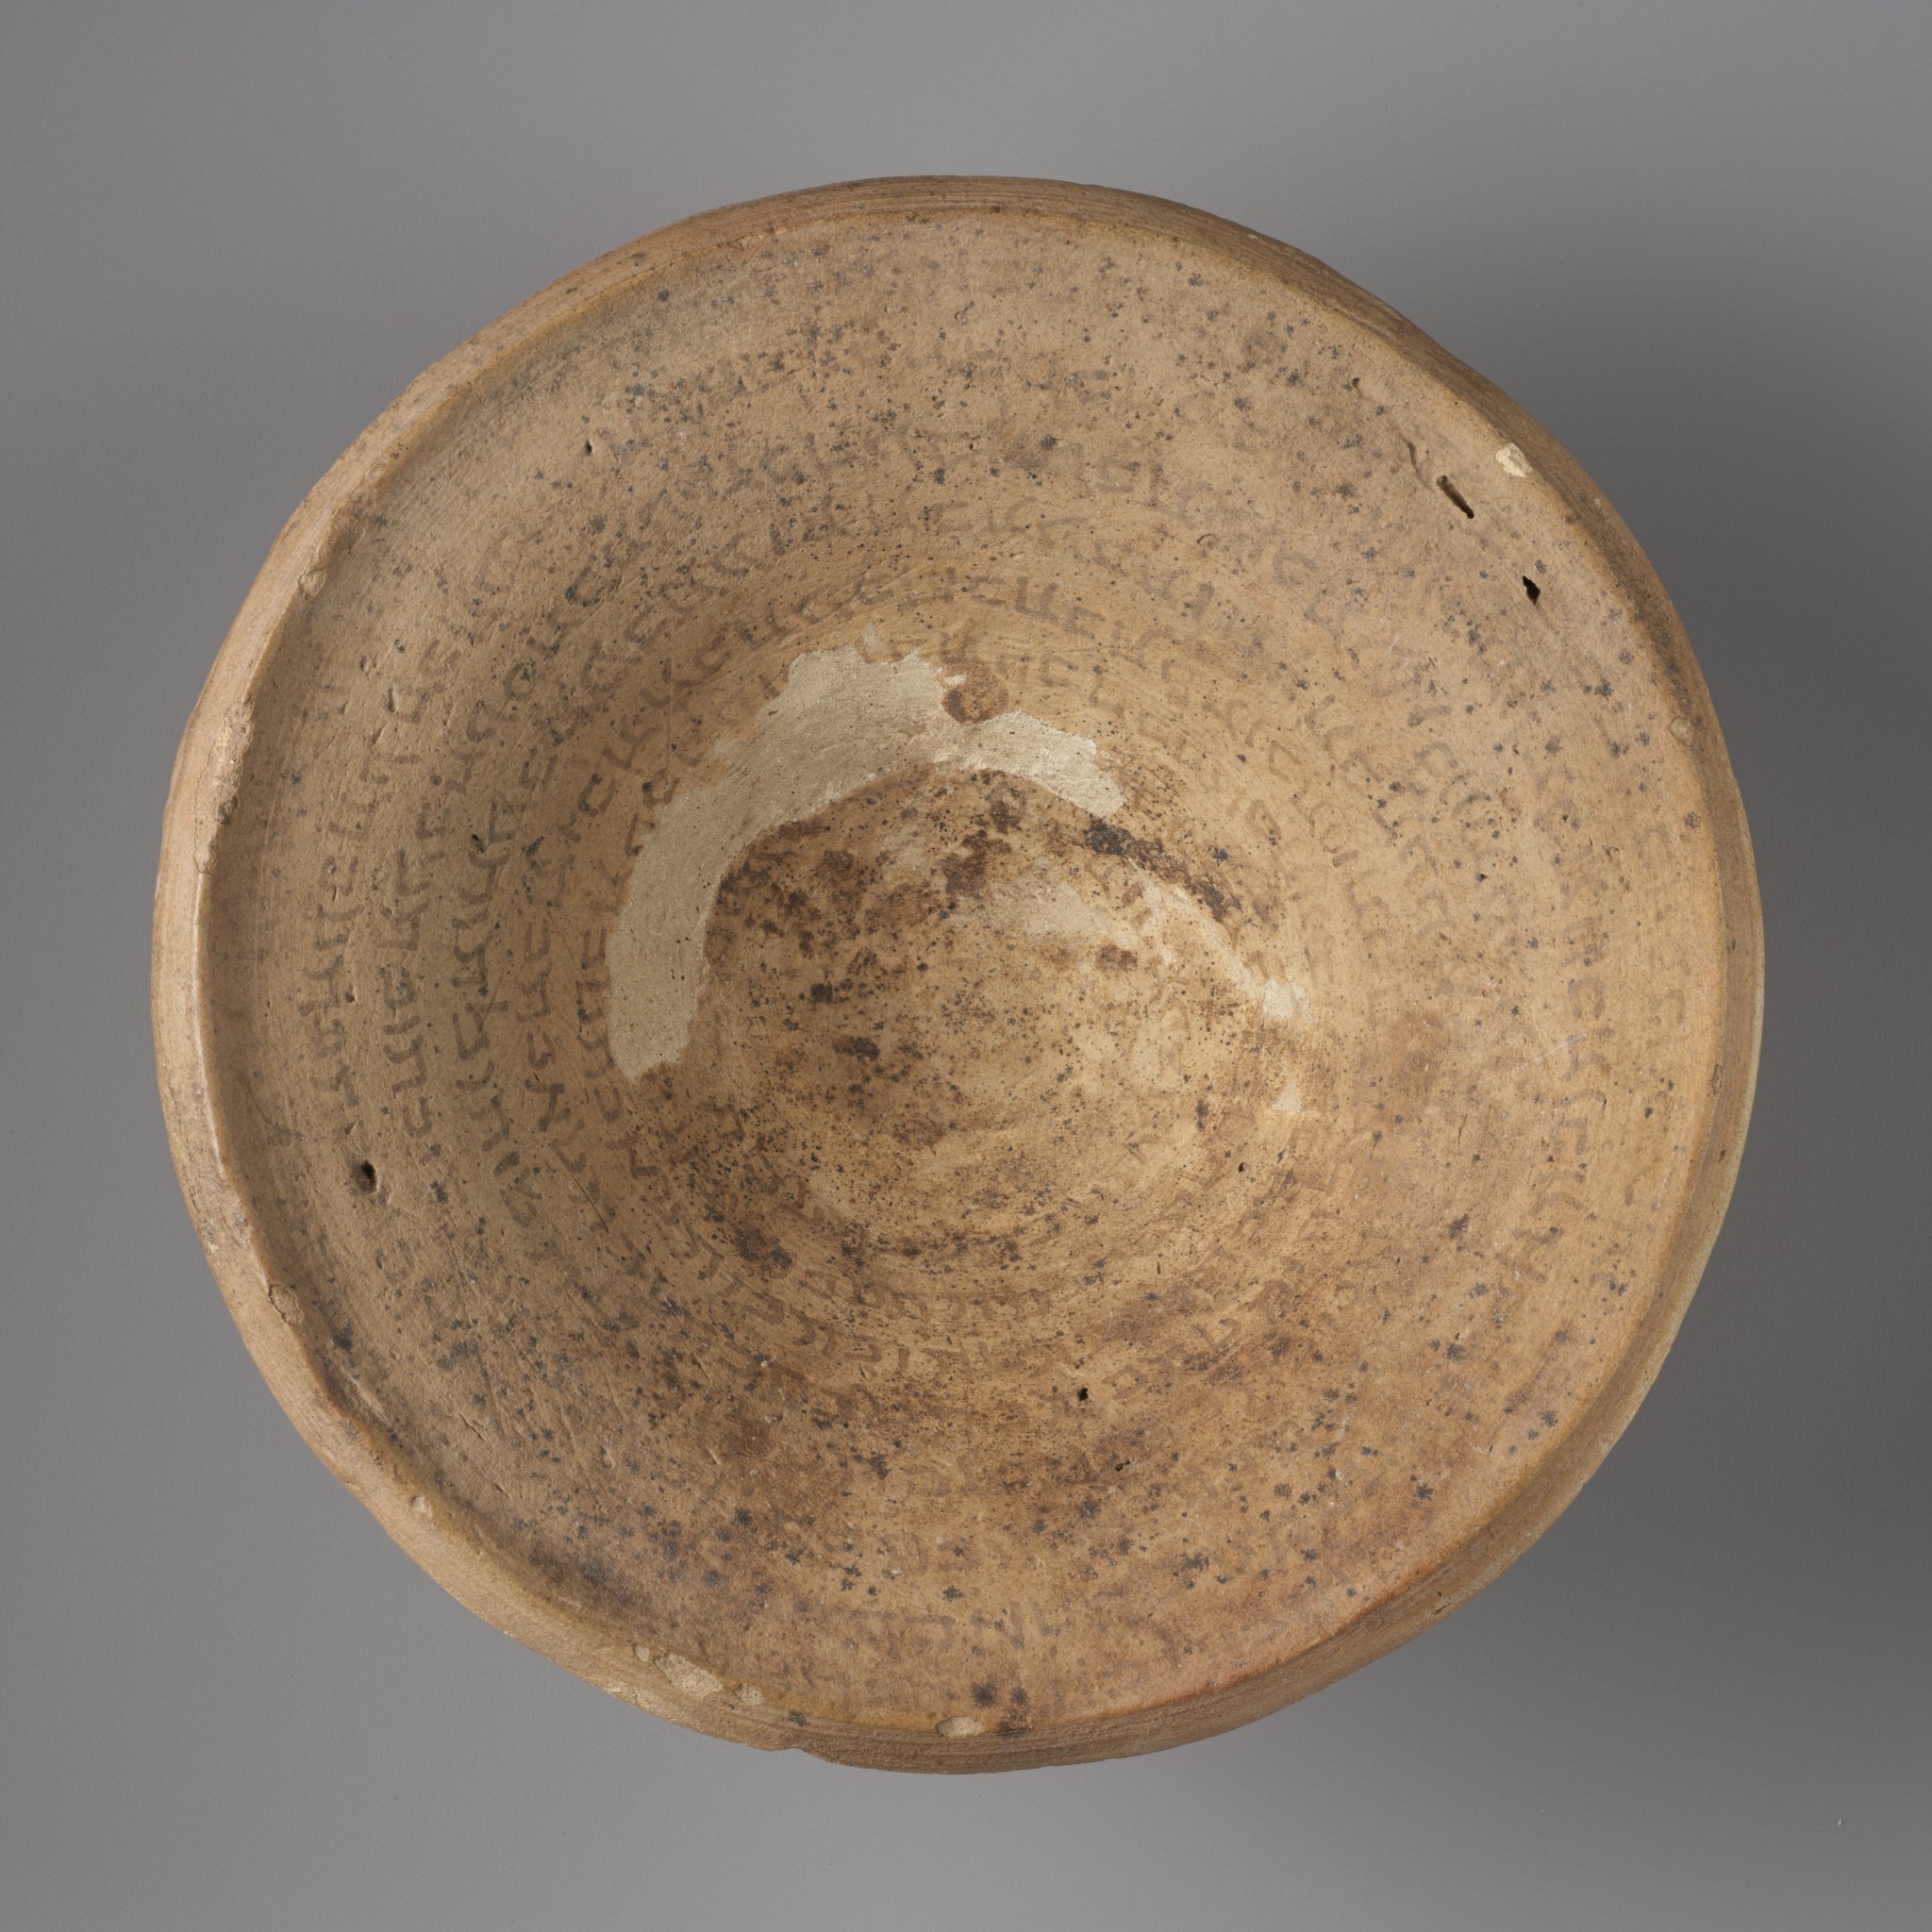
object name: bowl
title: Incantation bowl with pseudo-Aramaic inscription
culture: sasanian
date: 401-600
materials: ceramic, paint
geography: mesopotamia